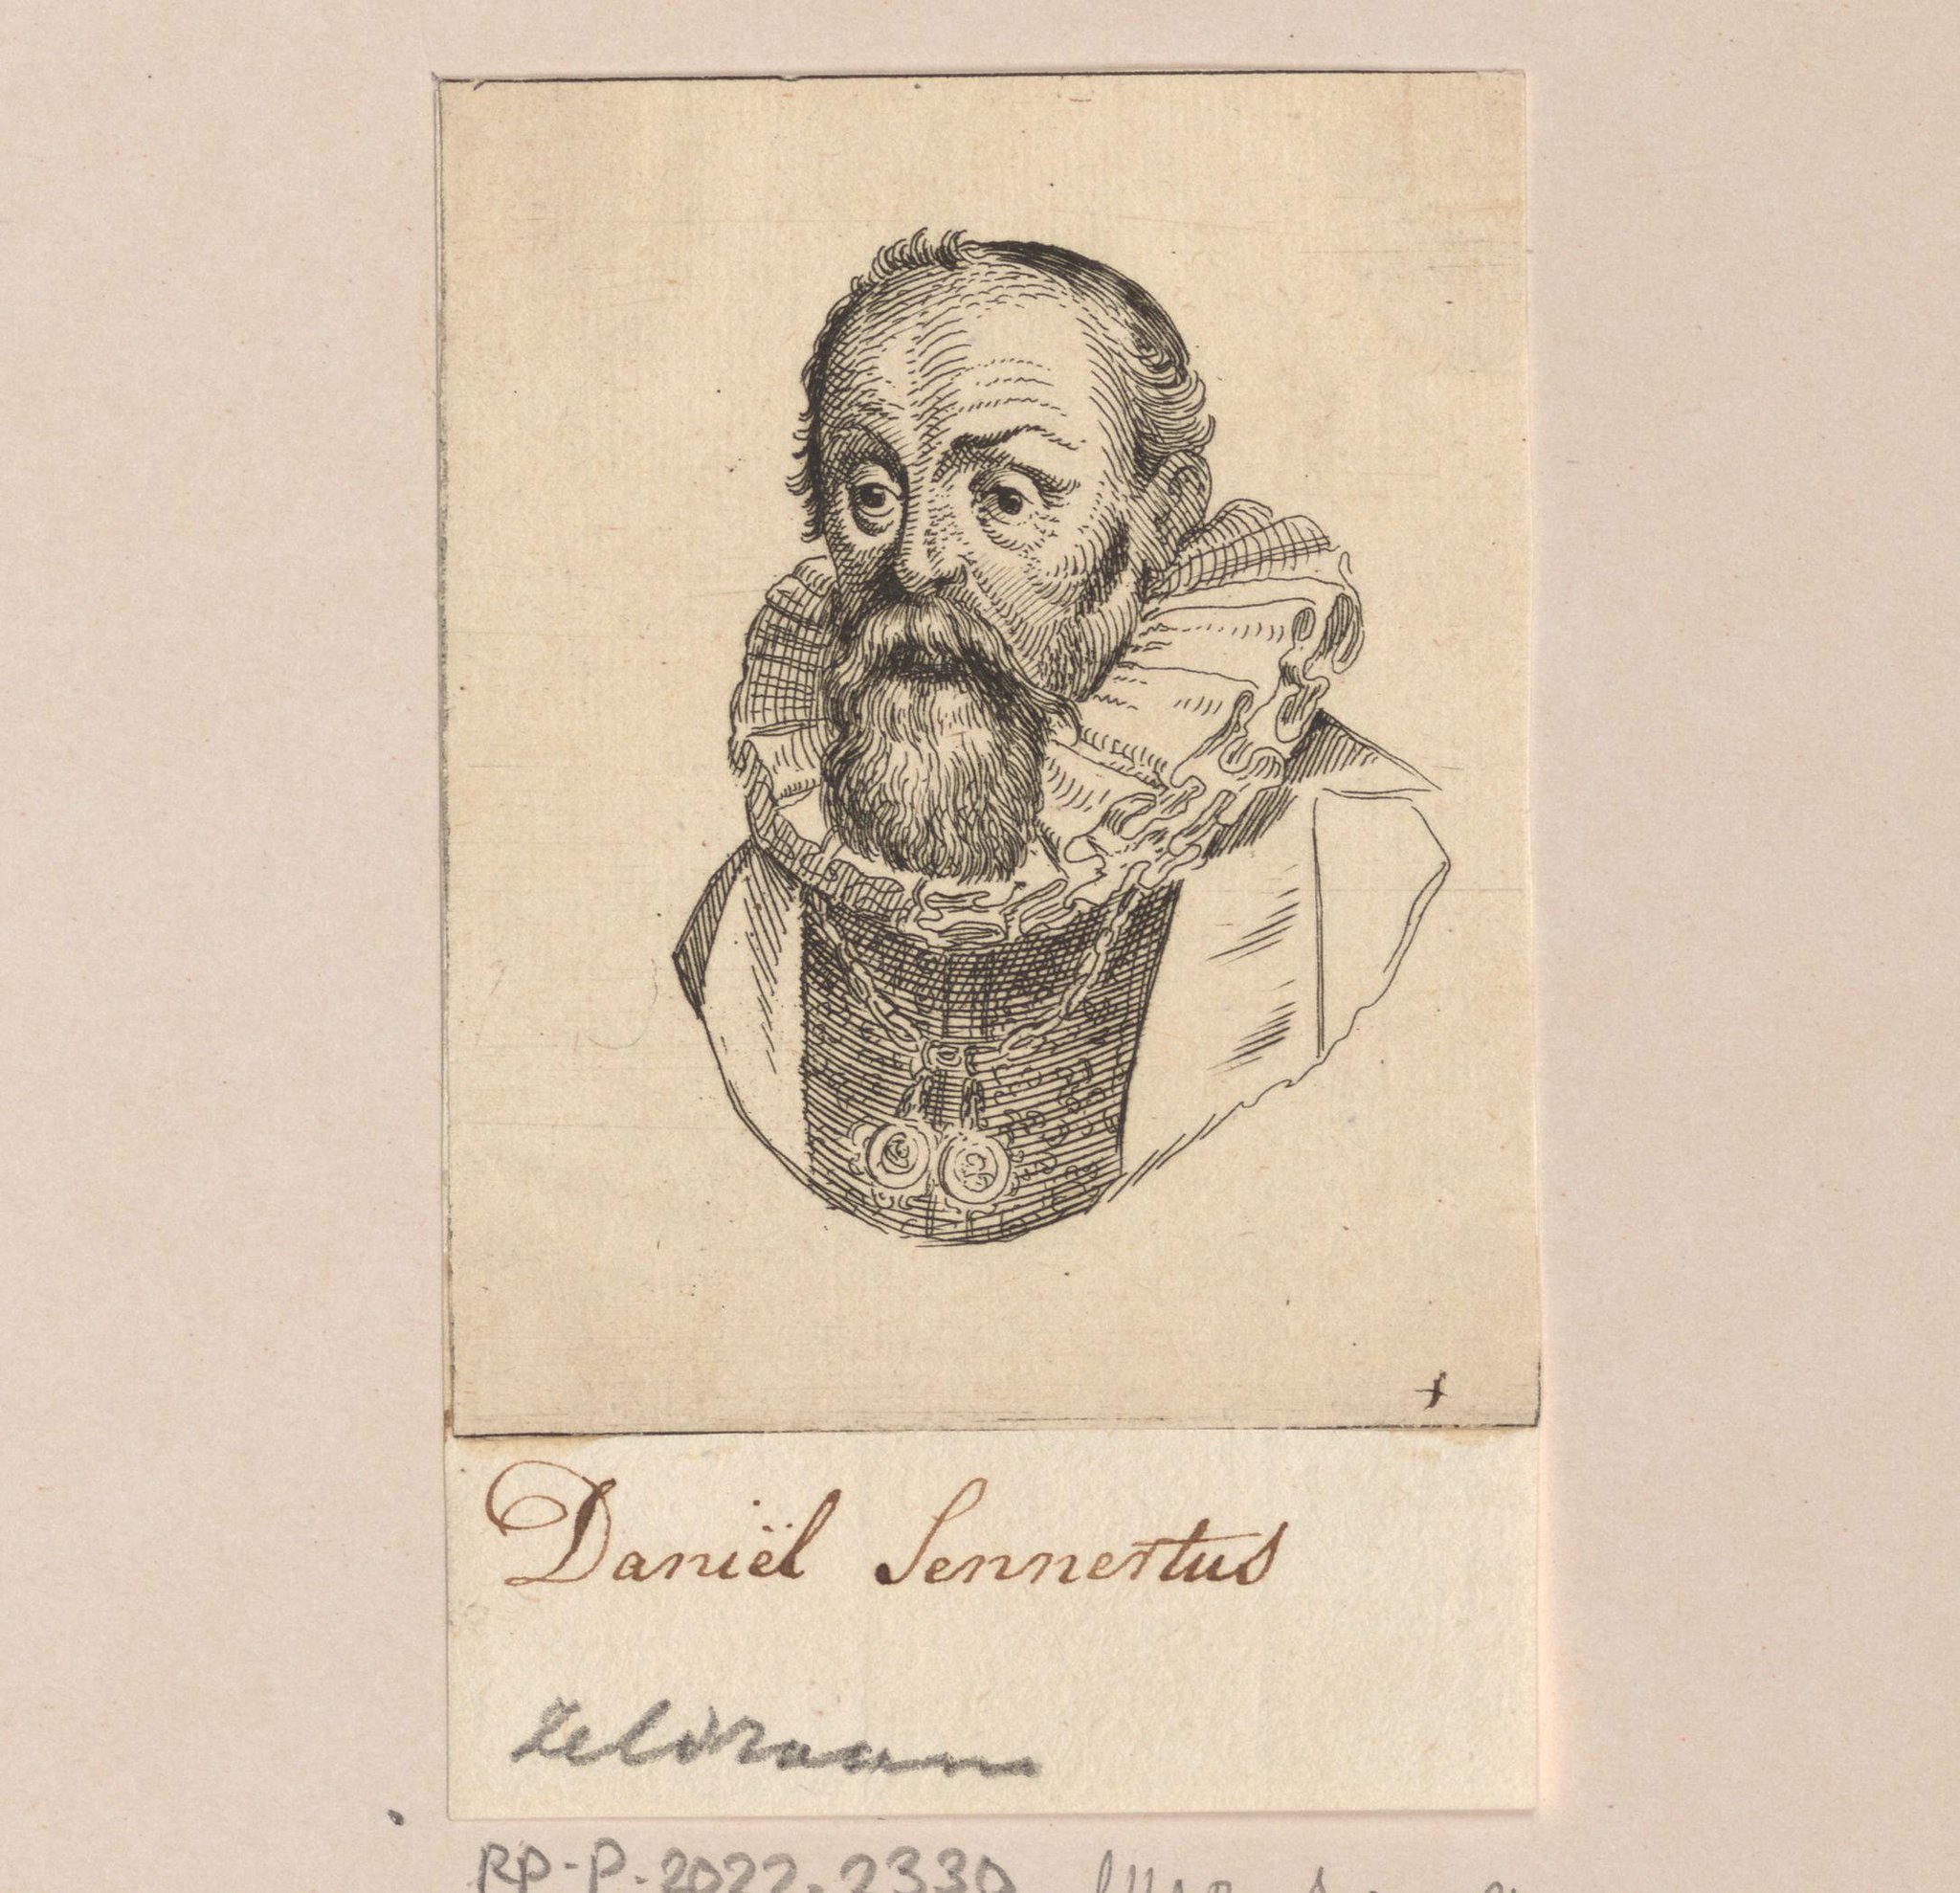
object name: print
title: Portret van Daniel Sennert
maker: Anonymous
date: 1600-1699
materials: paper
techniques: etching, snipping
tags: scholar, philosopher, historical persons, physician, doctor, professor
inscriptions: name: ‘Daniël Sennertus’